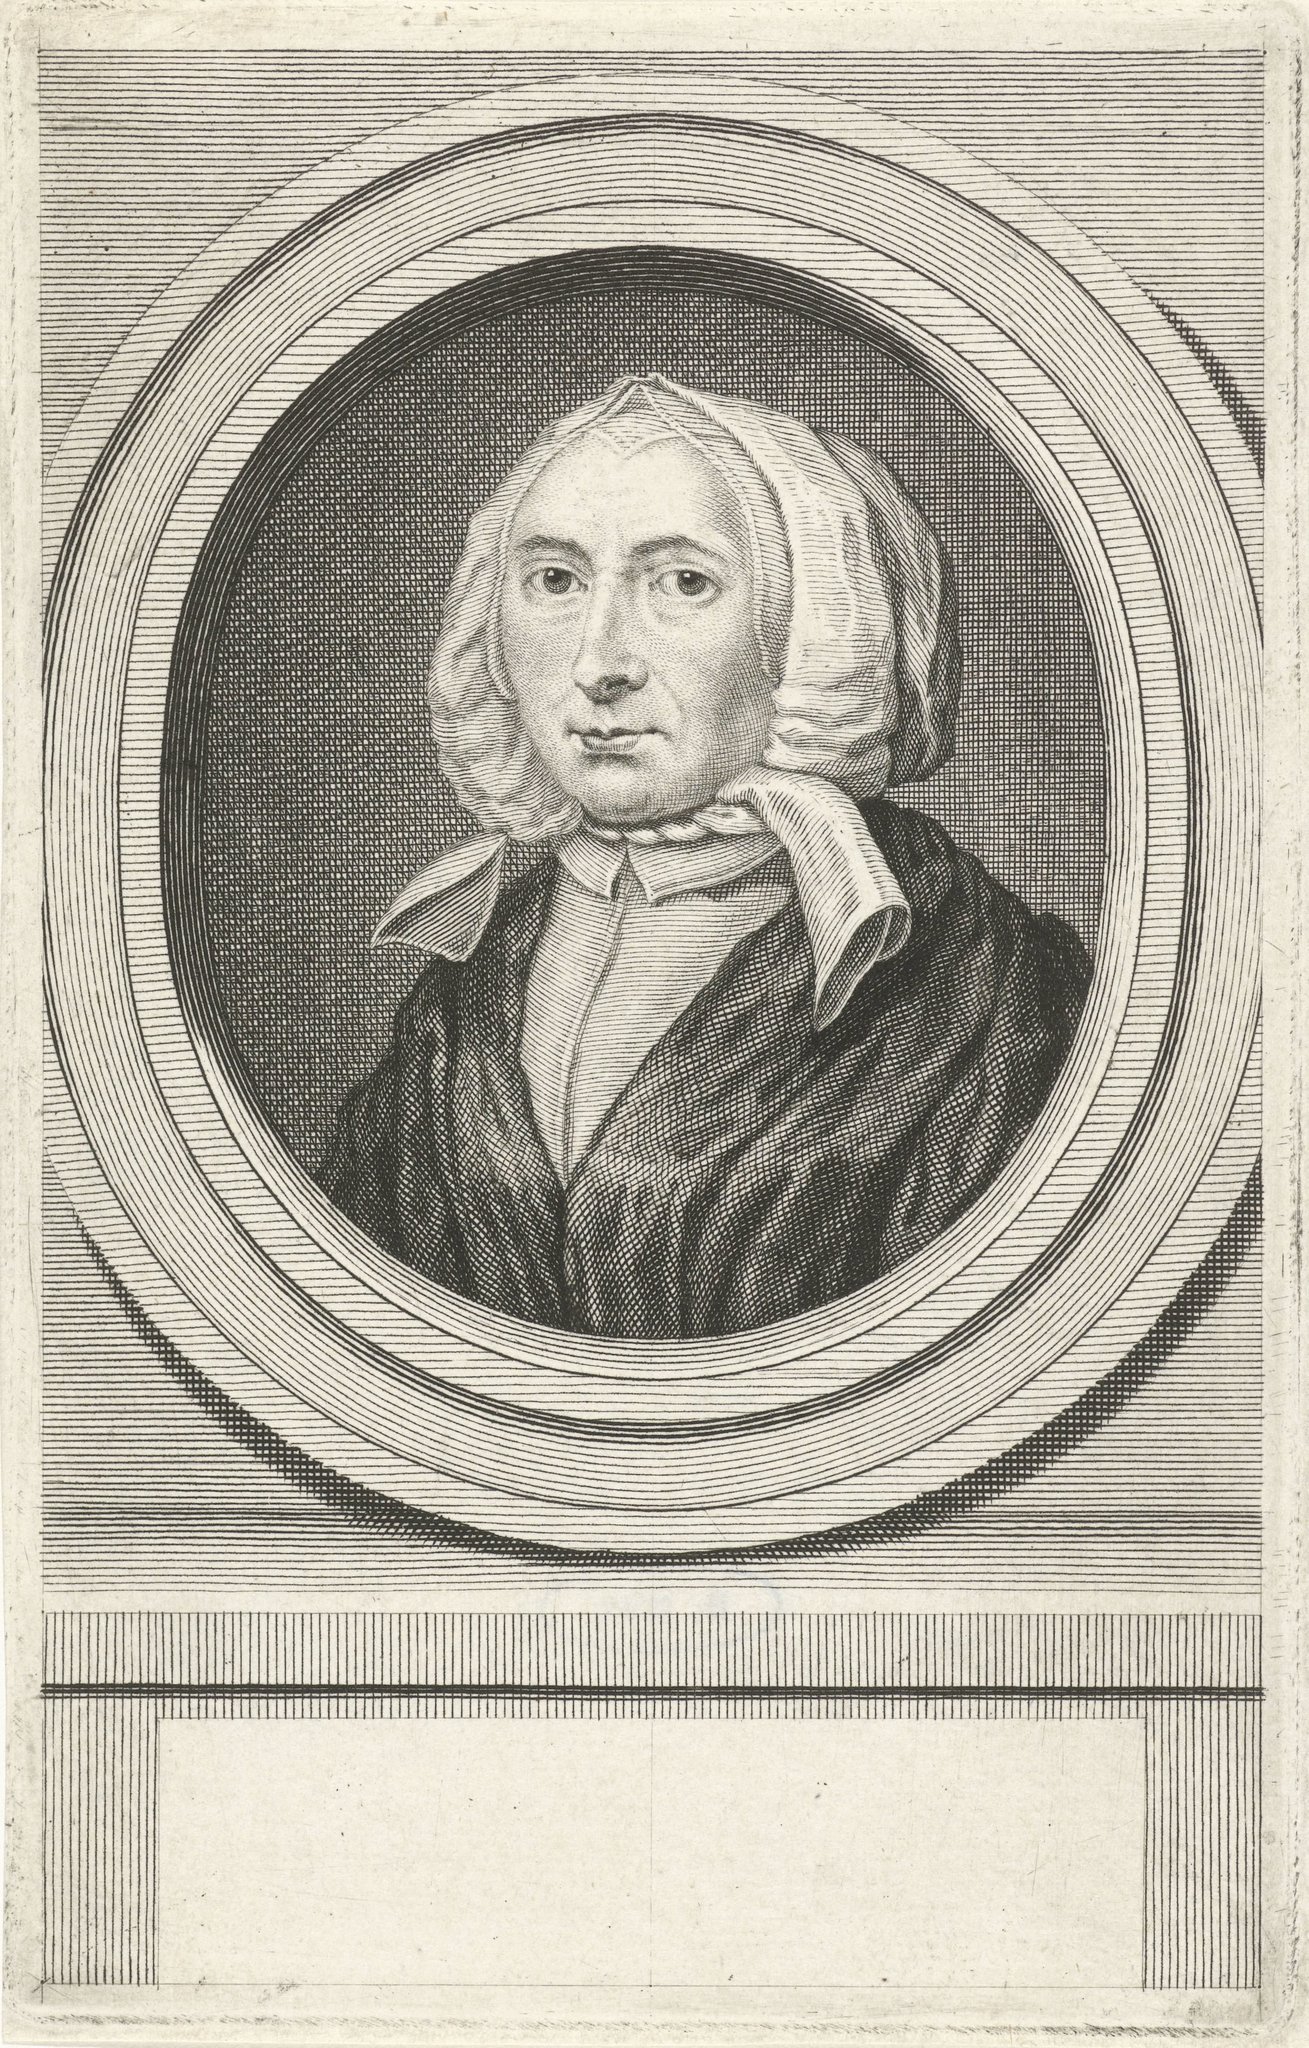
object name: print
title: Portret van Anna Maria van Schurman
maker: jan van munnickhuysen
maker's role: draughtsman, print maker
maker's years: 1655-1701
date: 1678-1680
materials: paper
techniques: engraving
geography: netherlands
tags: cologne, print maker, draughtsman, anna maria van schurman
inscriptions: collector's mark: Lugt 2228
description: Portret van Anna Maria van Schurman, dichteres en prentmaakster.